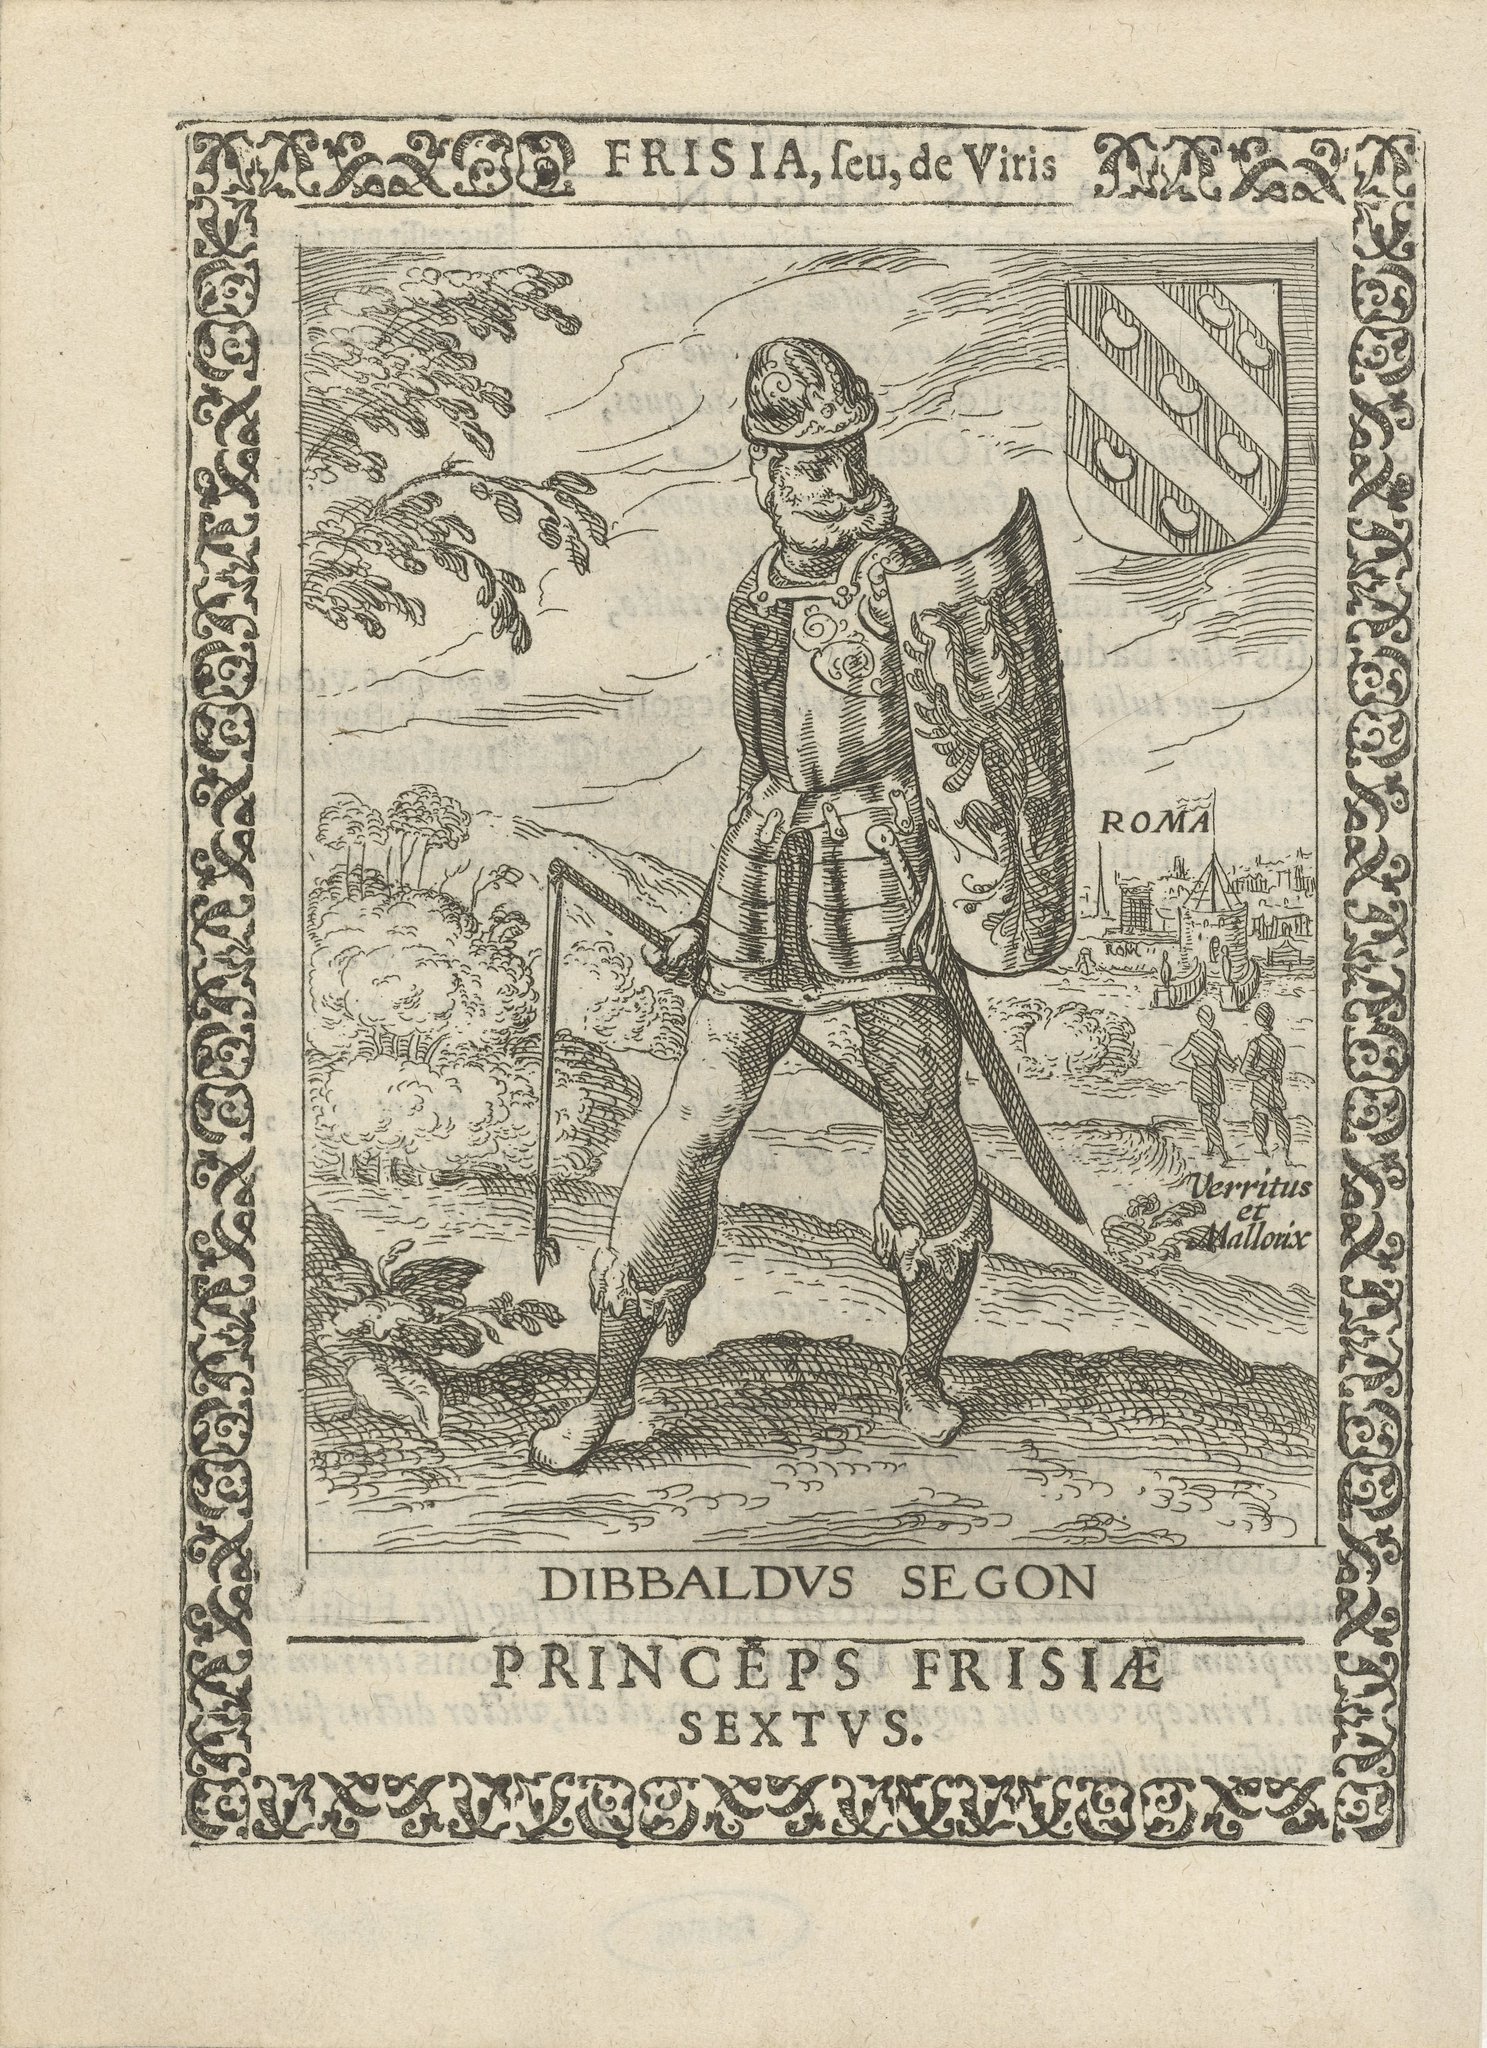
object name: print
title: Dibbaldus Segon. Princeps Frisiae Sextus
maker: pieter feddes van harlingen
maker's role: painter, print maker, publisher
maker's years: 1586-1623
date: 1618-1620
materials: paper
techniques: etching, letterpress printing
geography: friesland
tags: ruler, sovereign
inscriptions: collector's mark: Lugt 2228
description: Dibbaldus Segon, zesde prins der Friezen. Staande ten voeten uit, gebroken lans en schild in de hand. Op de achtergrond Rome. In een ornamentale omlijsting. Illustratie, met tekst op achterzijde, afkomstig uit het boek: Frisia seu de viris rebusque Frisiae illustribus libri duo.